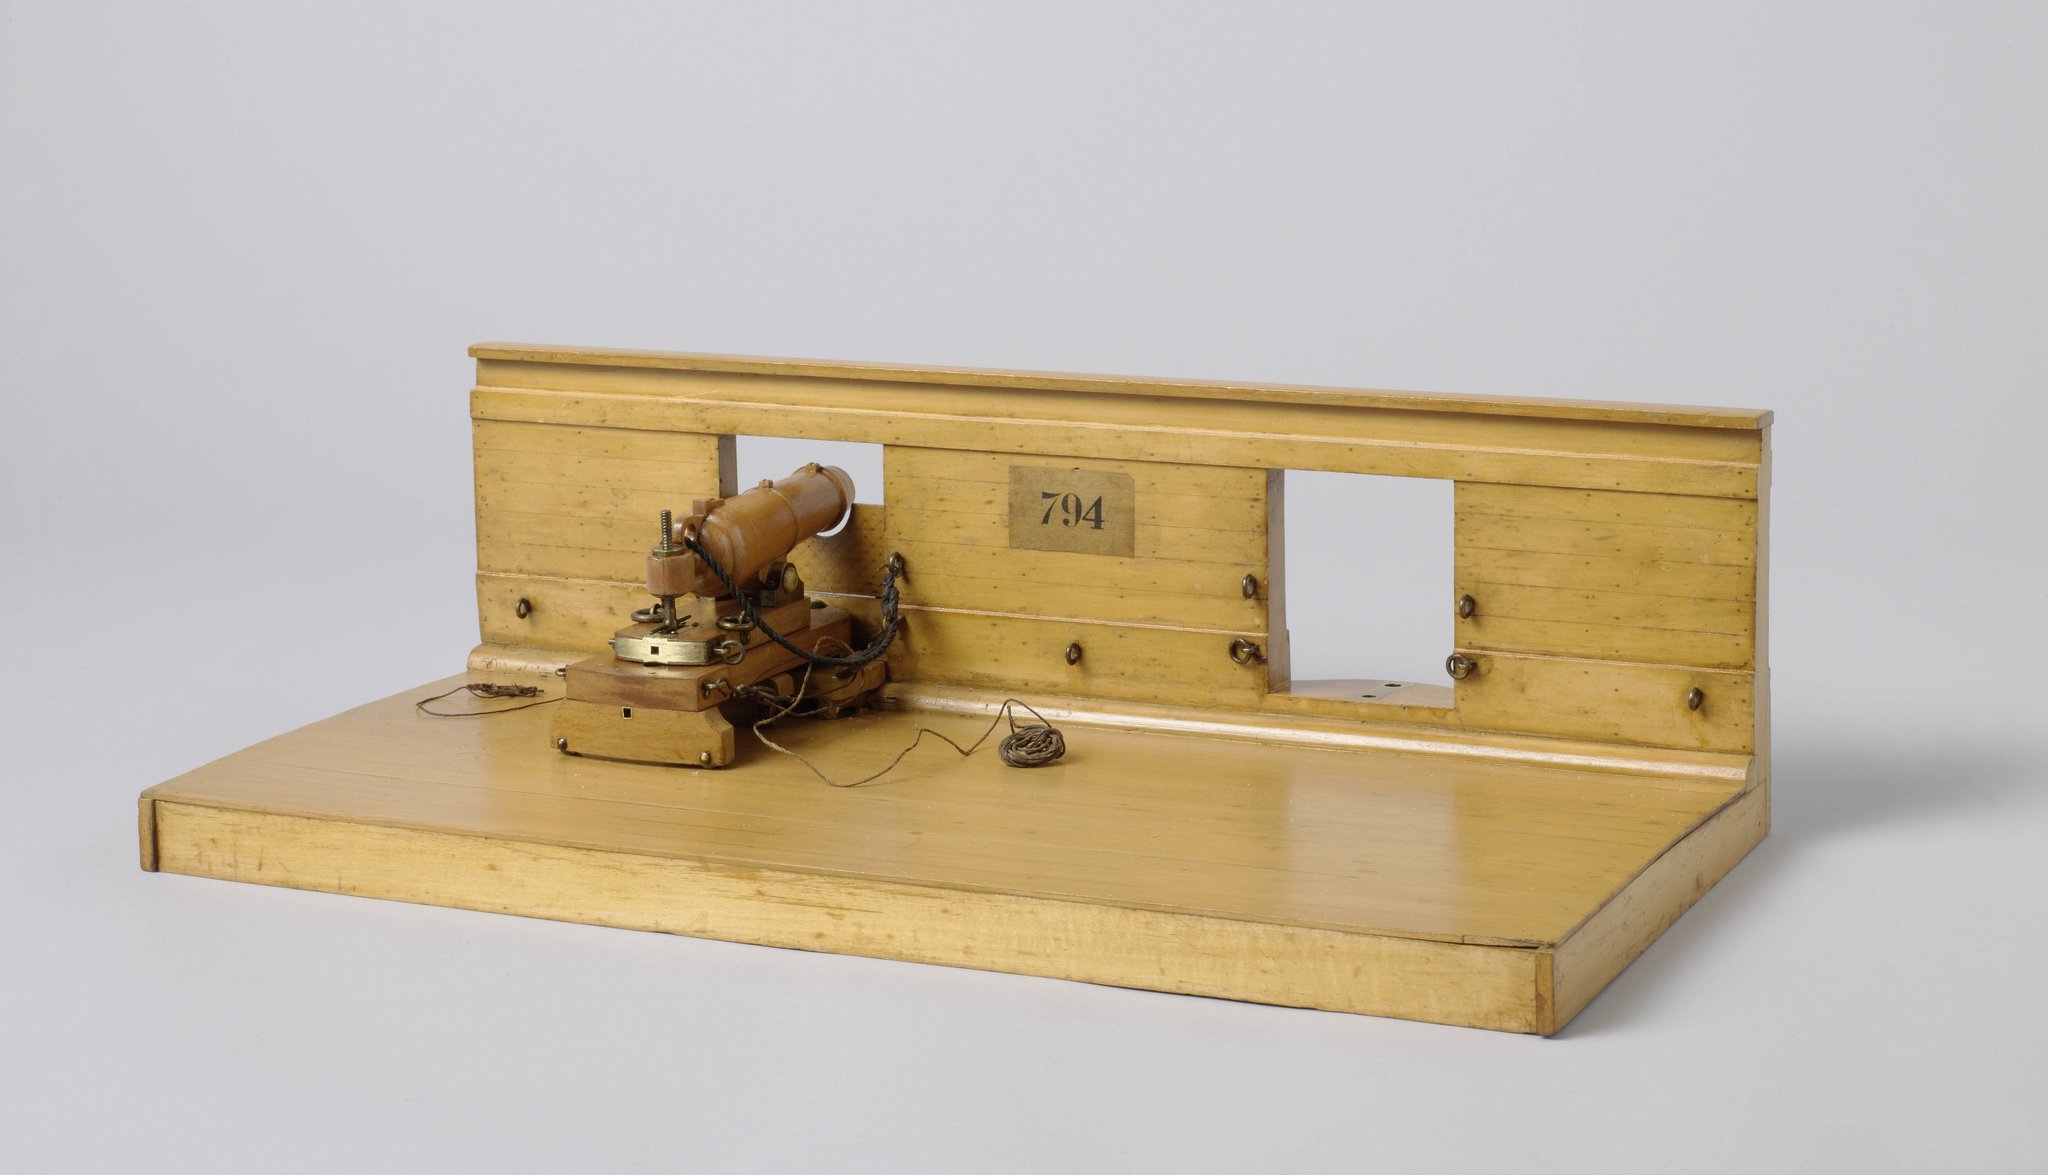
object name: demonstration model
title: Model of a 30-Pounder Carronade on Deck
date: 1819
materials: brass, fiber, wood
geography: netherlands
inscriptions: label, on the part of the ship: ‘794’ former inventory label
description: Model van een carronade van 30 pond op affuit op een scheepsdeel, incompleet. De houten loop is 14 cm lang en niet uitgeboord. Het heeft een eleveerschroef door de druif. De bovenslede heeft een licht trapezevormig lichaam met messing beslag en ringen, de voor- en achterkant zijn afgerond. Tegen de achterkant de bakskoker in messing beslag en bovenop het spoor voor de eleveerschroef, aan de voorkant de oren met tapas en de wervelbout lopend in de gleuf van de onderslede. De onderslede is een houten raam, aan de voorkant afgerond, gedeeltelijk met messing beslagen en voorzien van twee bouten. Aan de achterkant verbreedt de onderslede en is een weinig afgerond. In het midden en achter wordt het raam ondersteund door klossen met wielen: de wielen in het midden lopen in de lengterichting; de wielen achter staan met hun assen radiaal ten opzichte van de spilbout. Het scheepsdeel heeft twee verschillende poorten: de ene heeft een bordes aan de binnenkant en een valpoort met ronde opening voor de loop, de andere heeft een bordes aan de buitenkant. Schaal 1:12,5 (schatting).